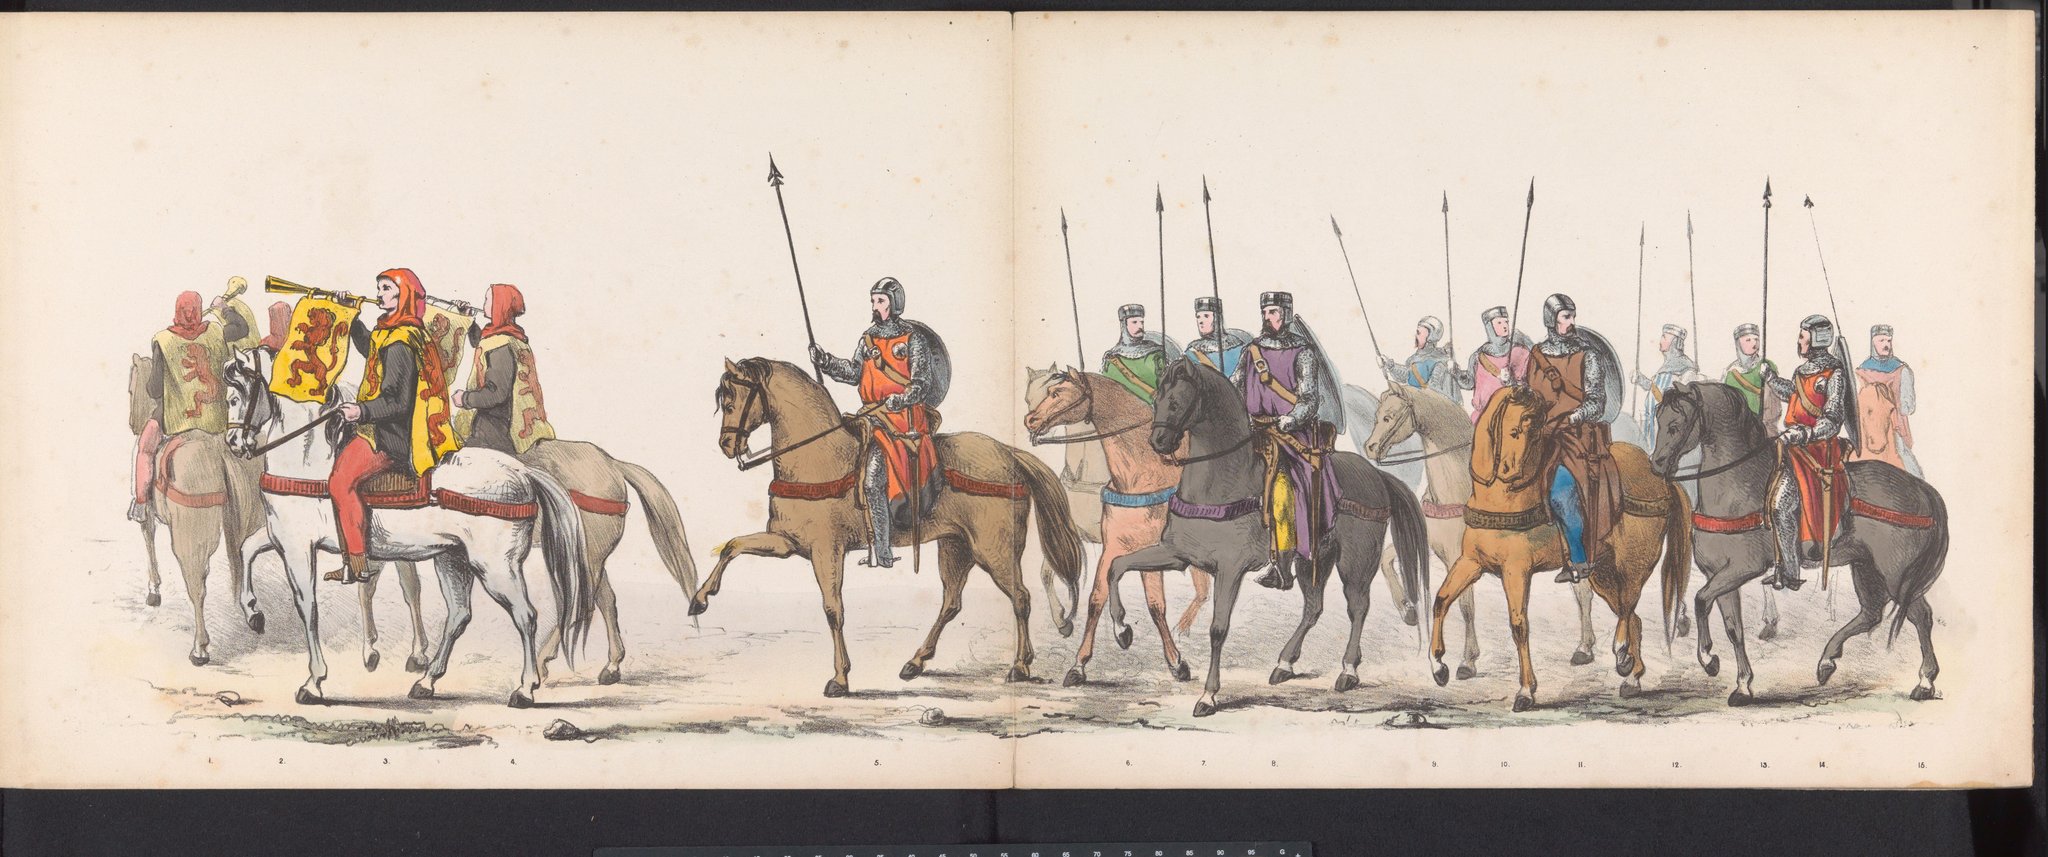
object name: print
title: Maskerade van de Leidse studenten, 1865 (plaat 1)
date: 1865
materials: paper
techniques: hand coloring, lithograph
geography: netherlands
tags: students' pageant, costumes used in pageants, leiden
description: Historische gekostumeerde optocht van de studenten van de Leidse Hogeschool gehouden op 6 juni 1865 ter gelegenheid van het 290-jarig bestaan van de Hogeschool. De optocht verbeeldt de intocht van de Hollanders binnen Zierikzee op 12 augustus 1304. Eerste plaat met de groepen genummerd 1-15. Onderdeel van de serie van 16 aaneen geplakte bladen.